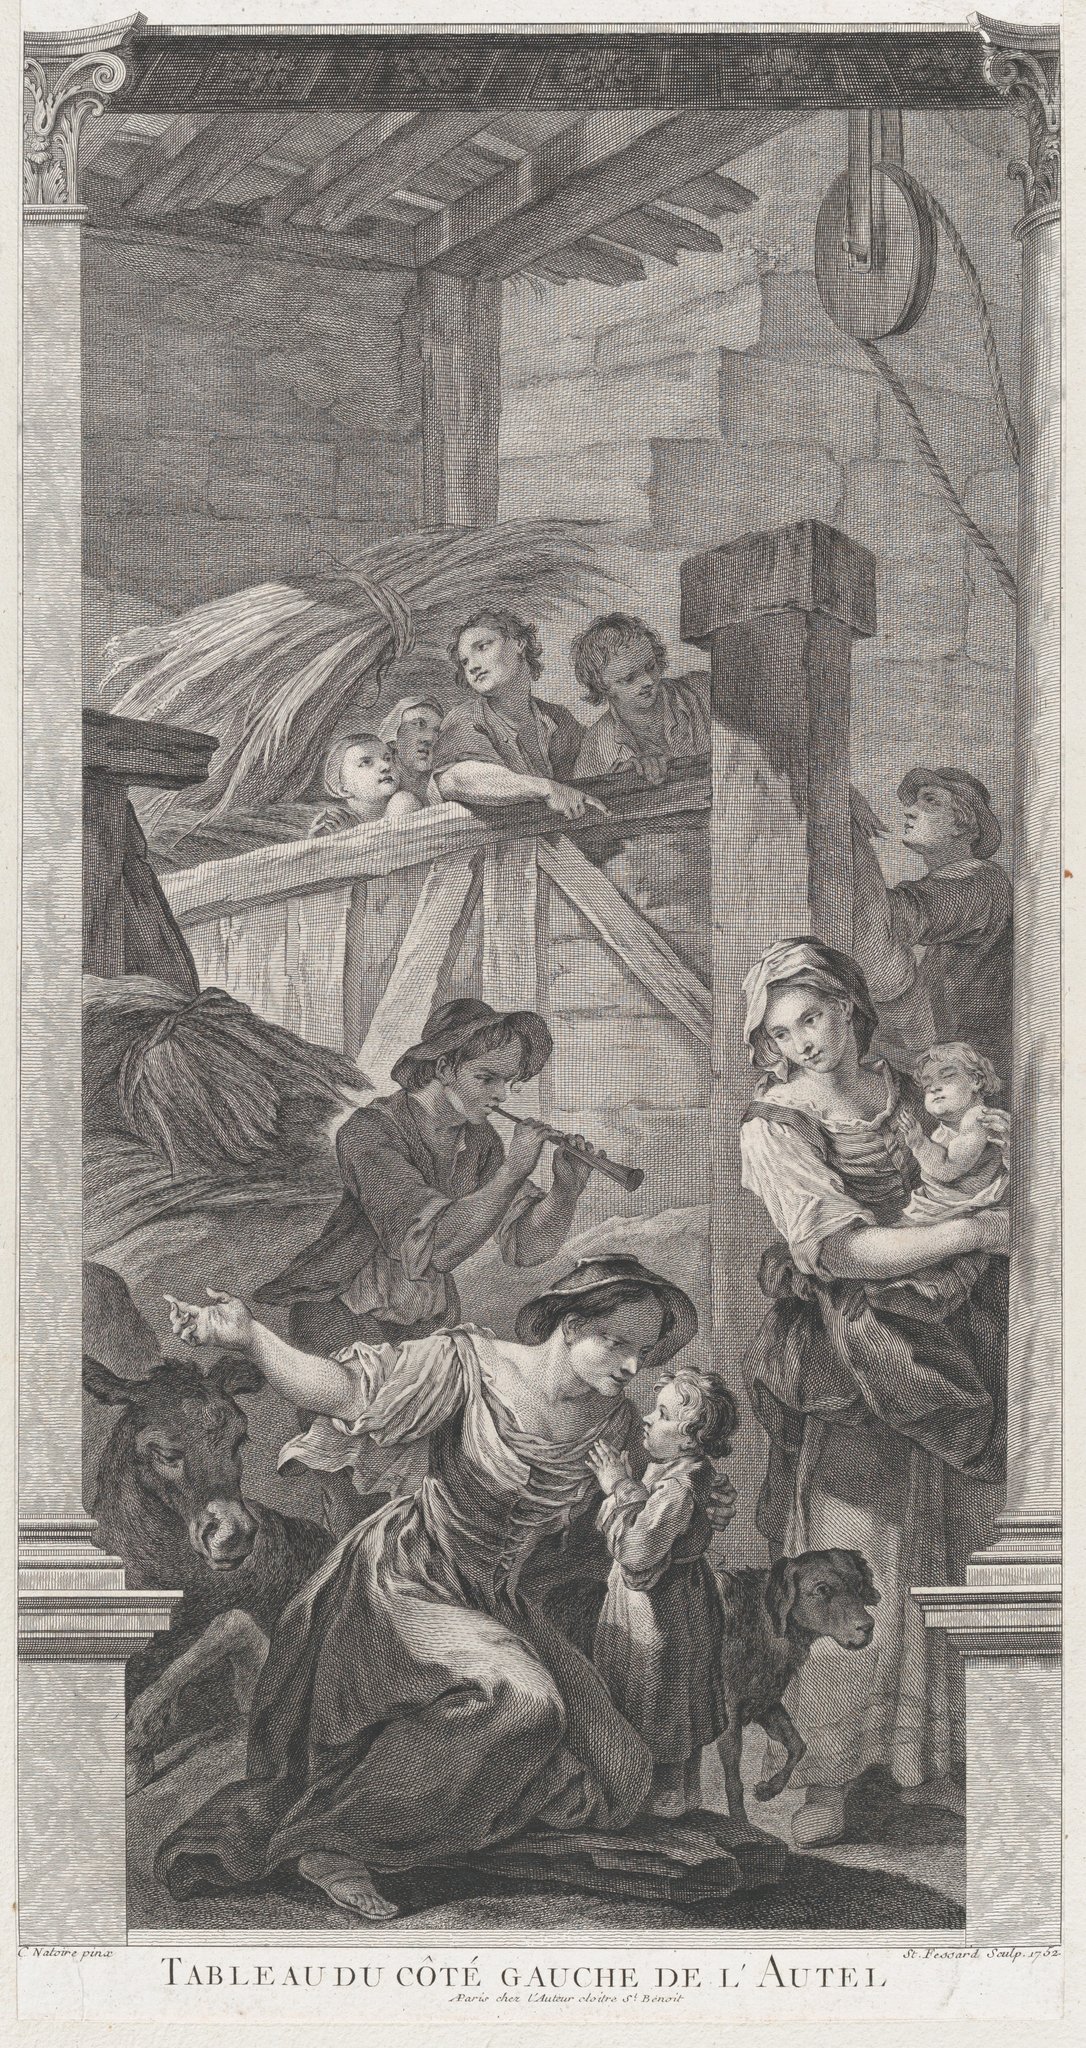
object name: print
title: The Chapel of the Enfants-Trouvés in Paris: L'Adoration des bergers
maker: etienne fessard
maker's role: artist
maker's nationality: french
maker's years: 1714-1777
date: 1752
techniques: engraving, etching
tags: children,women,dogs,donkeys,adoration of the shepherds